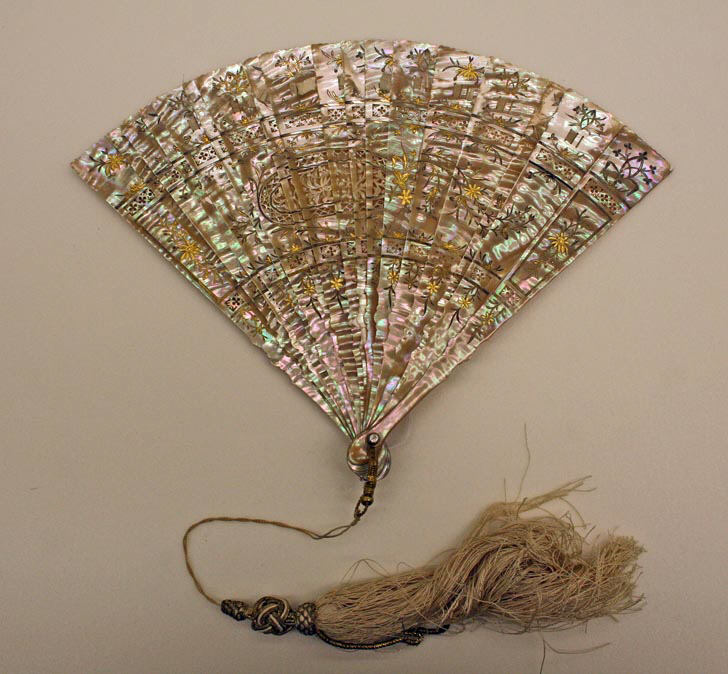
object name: brisé fan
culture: french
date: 1870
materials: metal, shell, silk